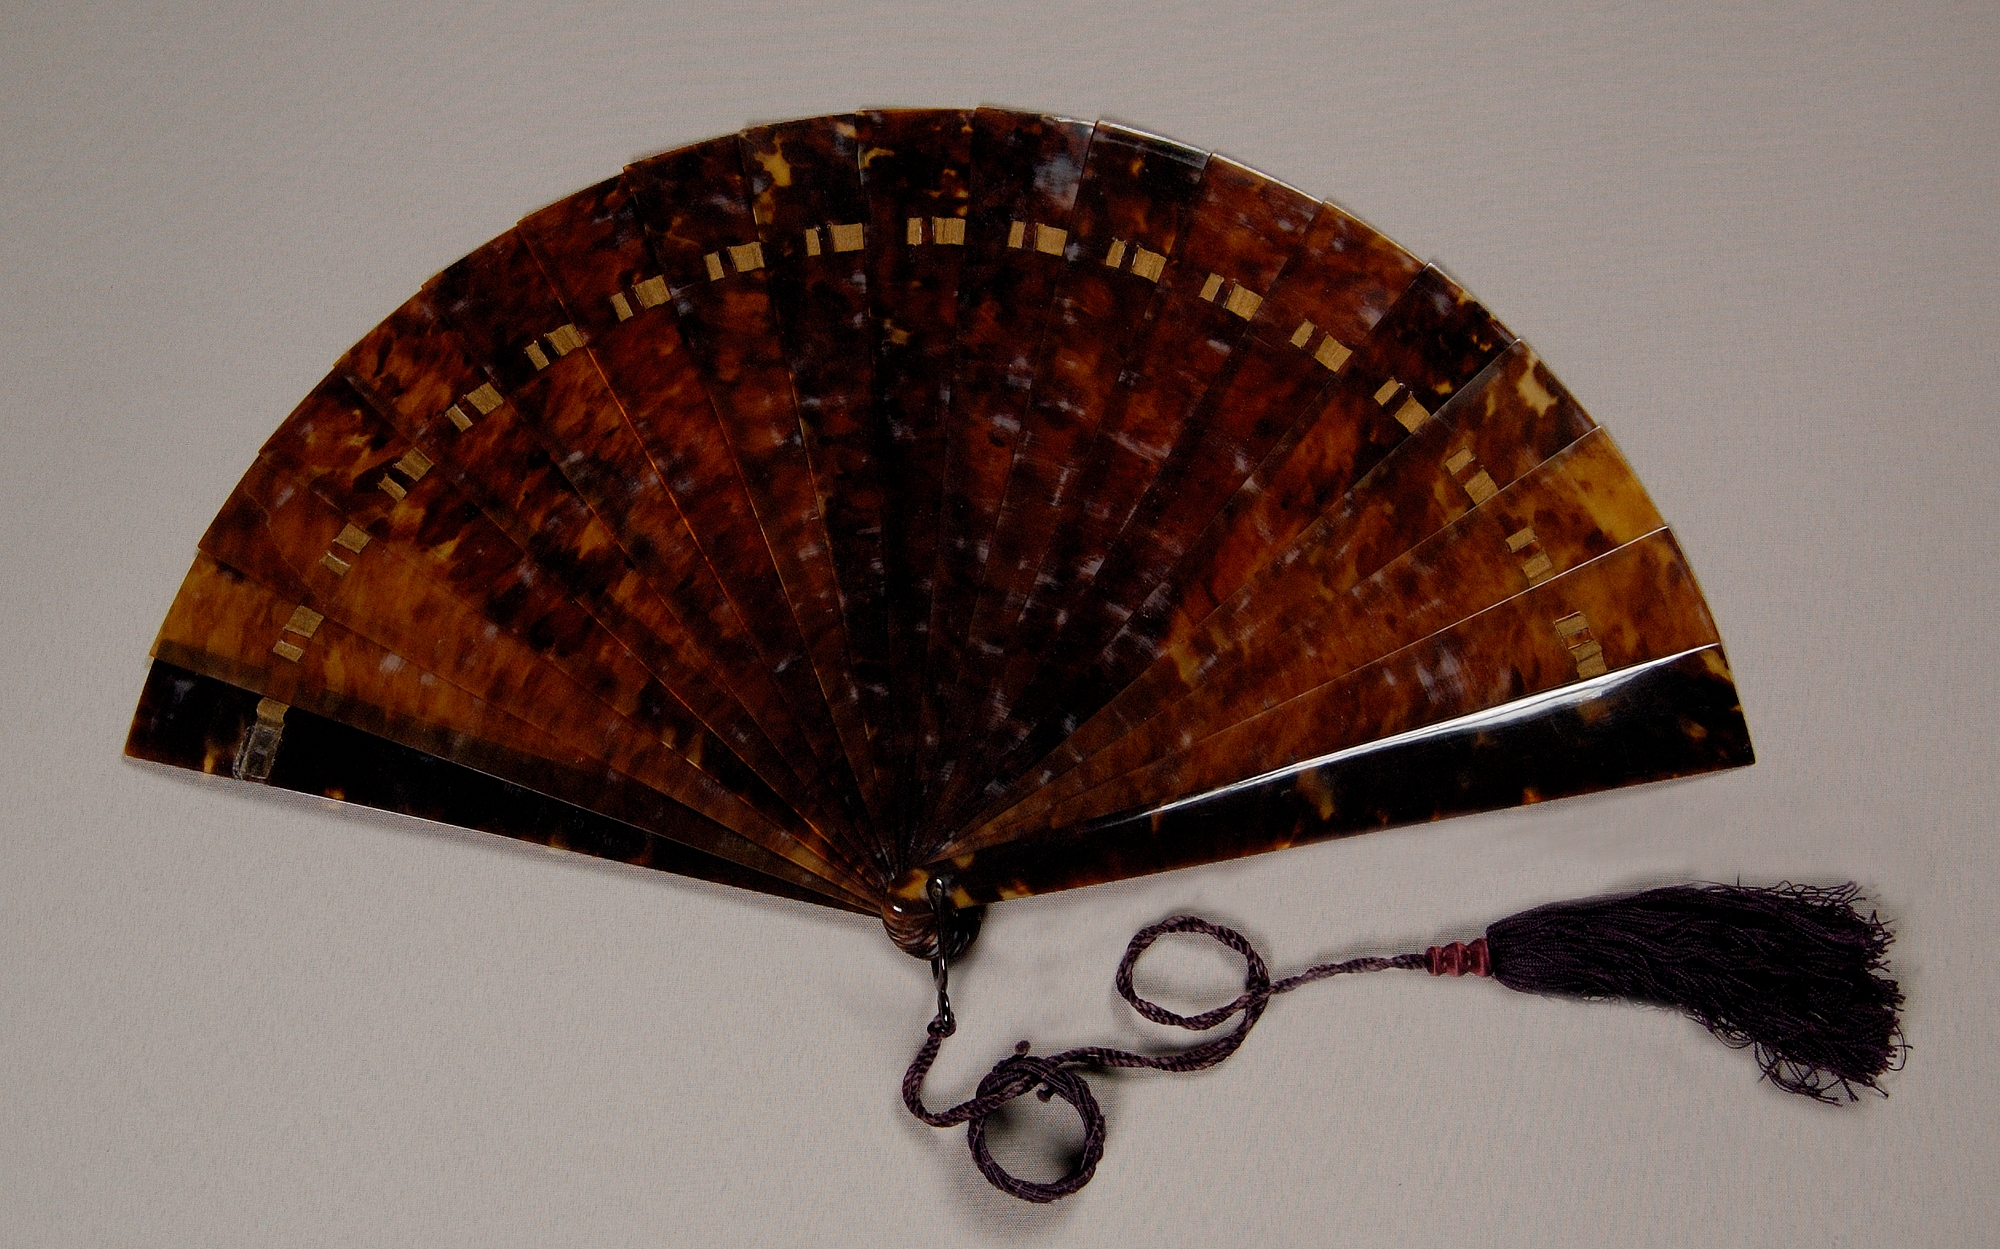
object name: brisé fan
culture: french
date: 1870-1889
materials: silk, shell